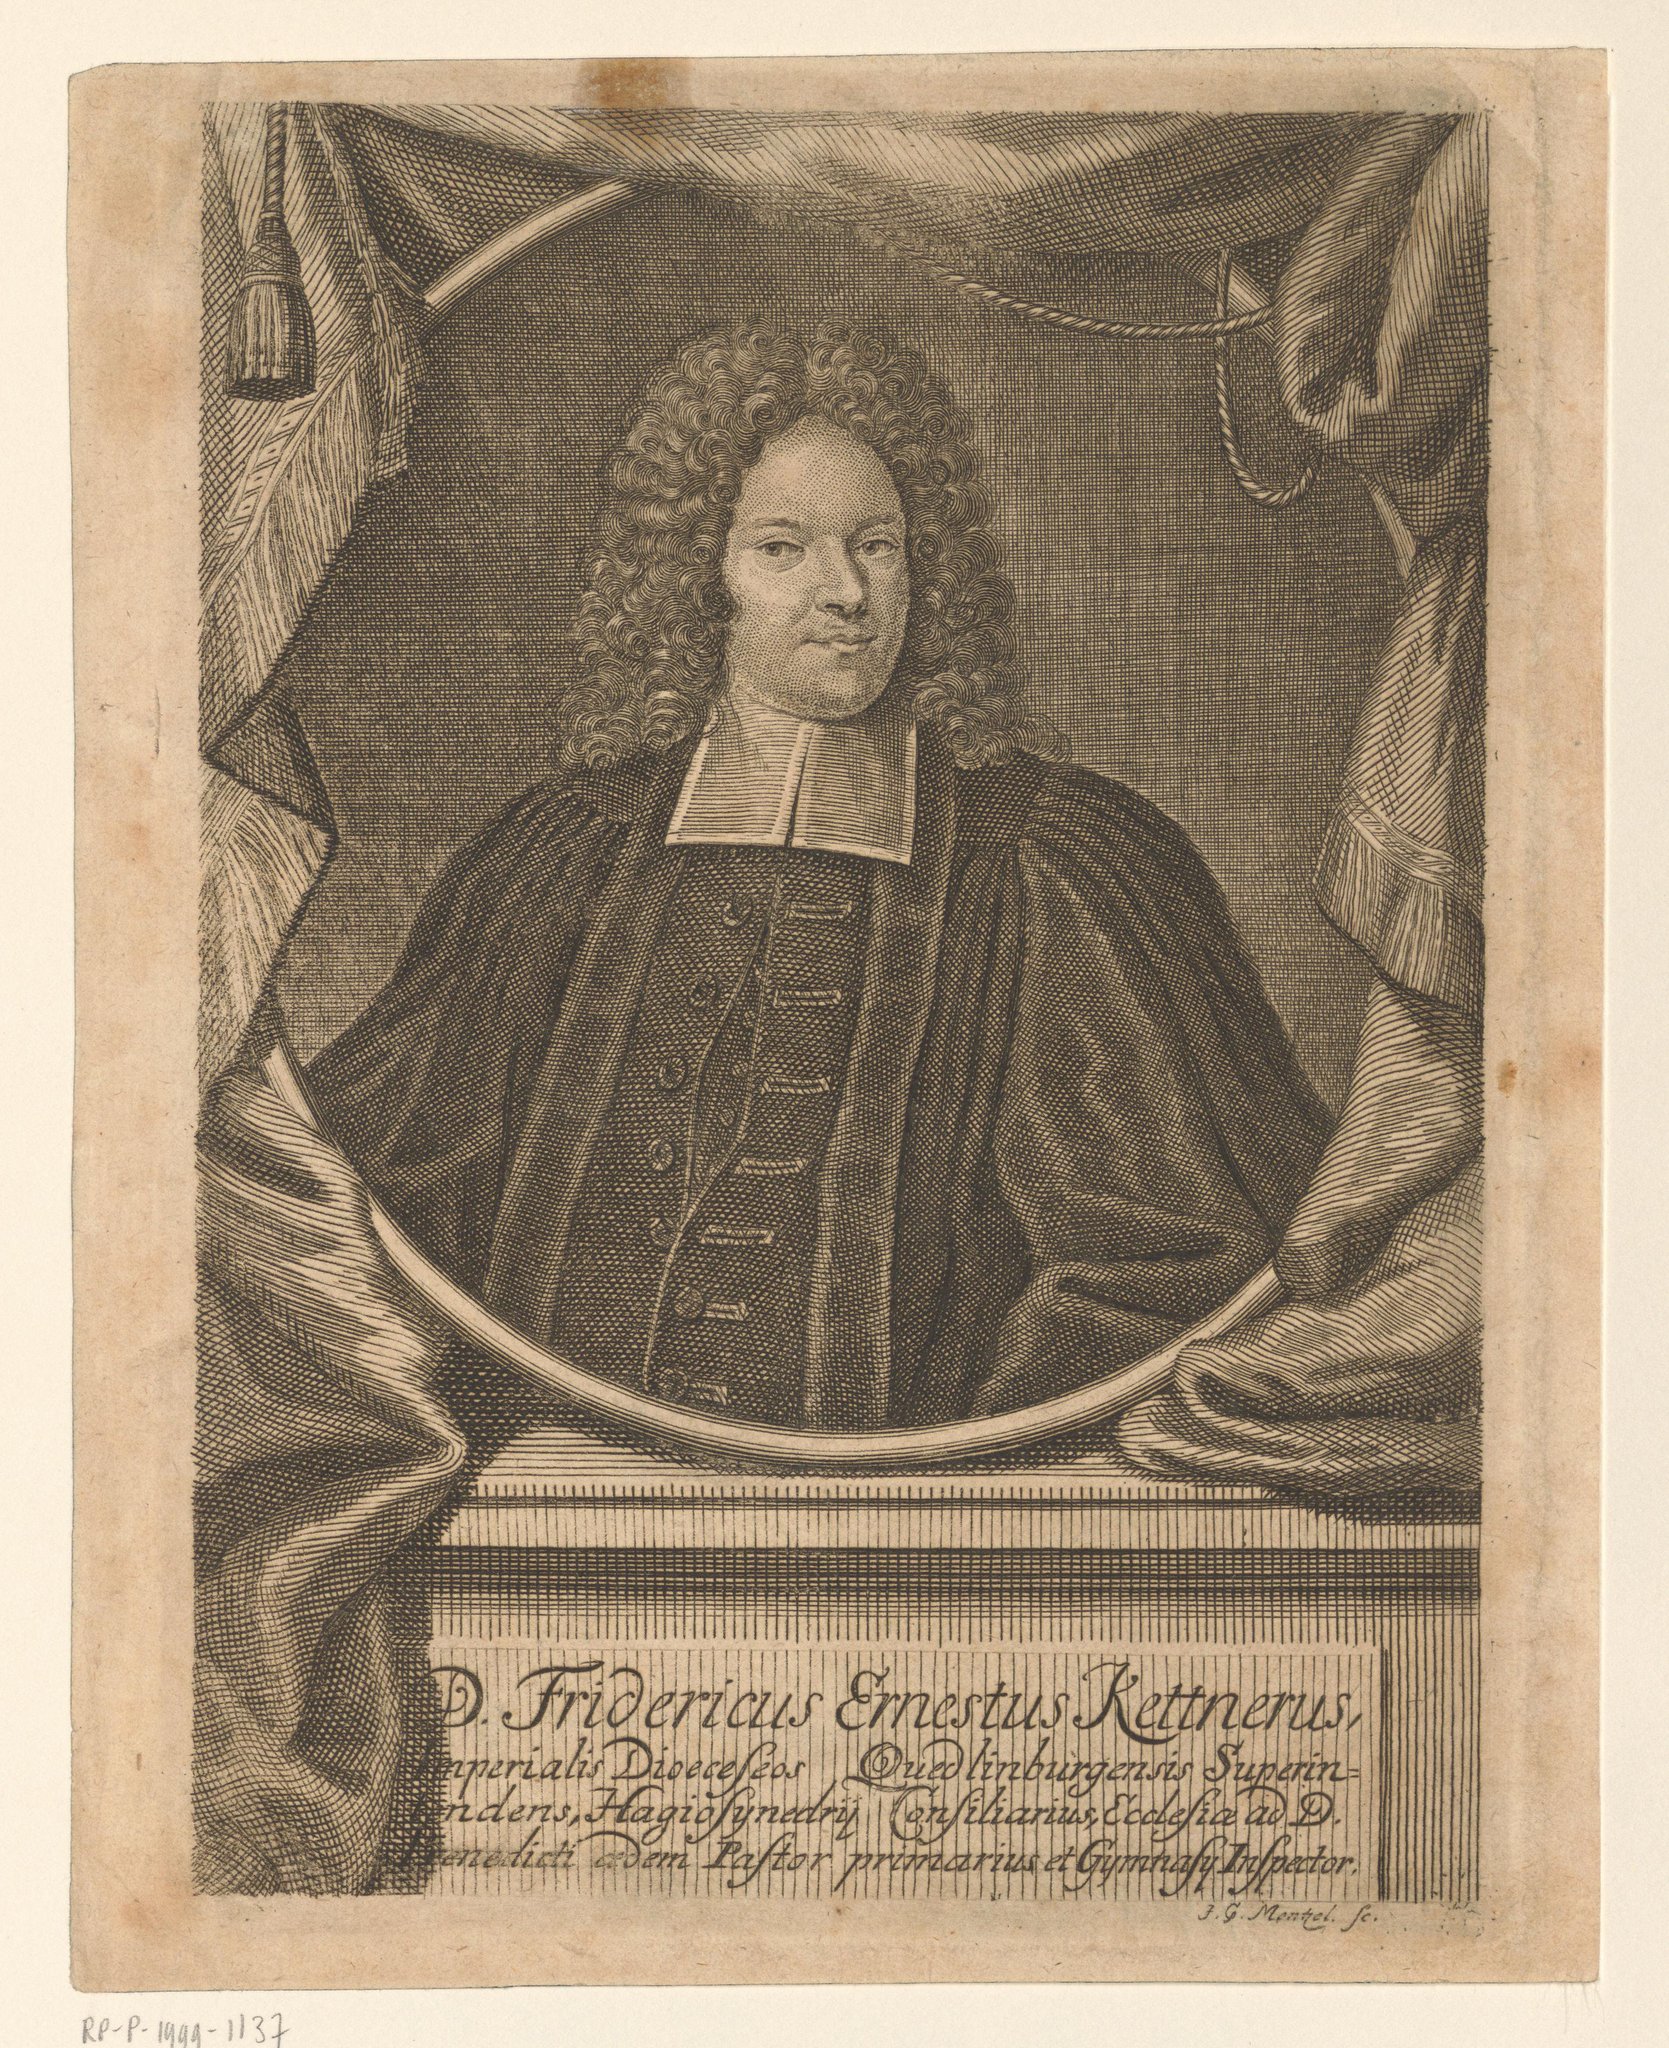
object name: print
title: Portret Fredericus Ernestus Kettner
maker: johann georg mentzel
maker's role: print maker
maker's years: 1677-1743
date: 1687-1744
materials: paper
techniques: engraving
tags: historical persons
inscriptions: collector's mark: Lugt 2228